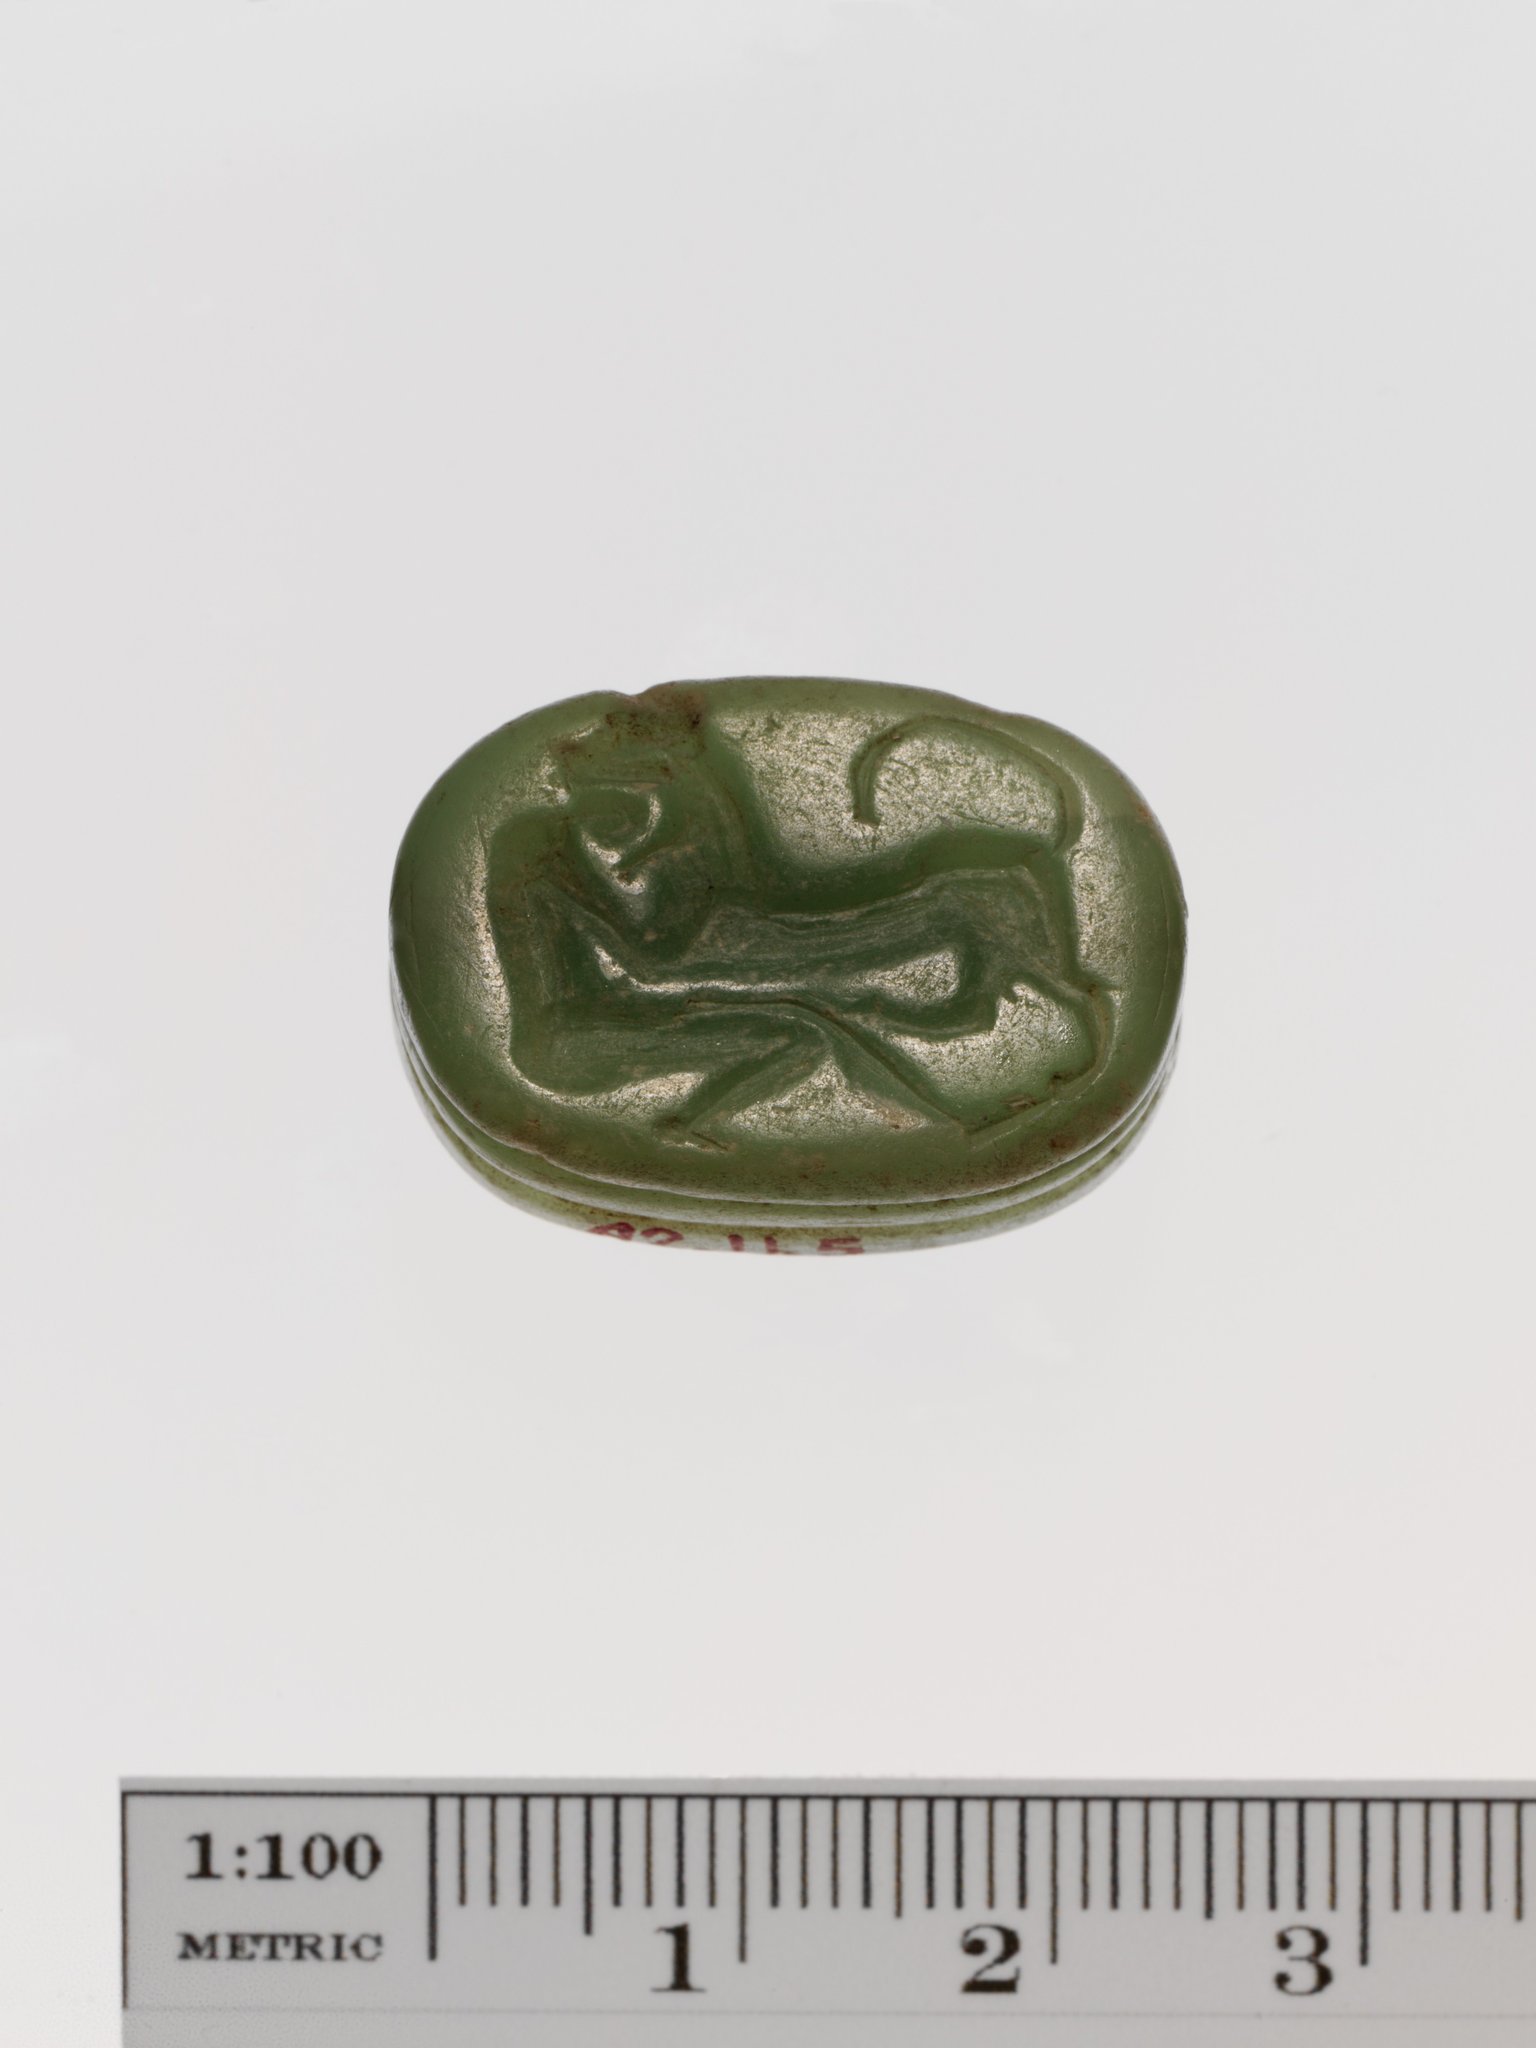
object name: scaraboid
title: Steatite scaraboid seal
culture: greek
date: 700-668 BCE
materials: stone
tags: men,lions